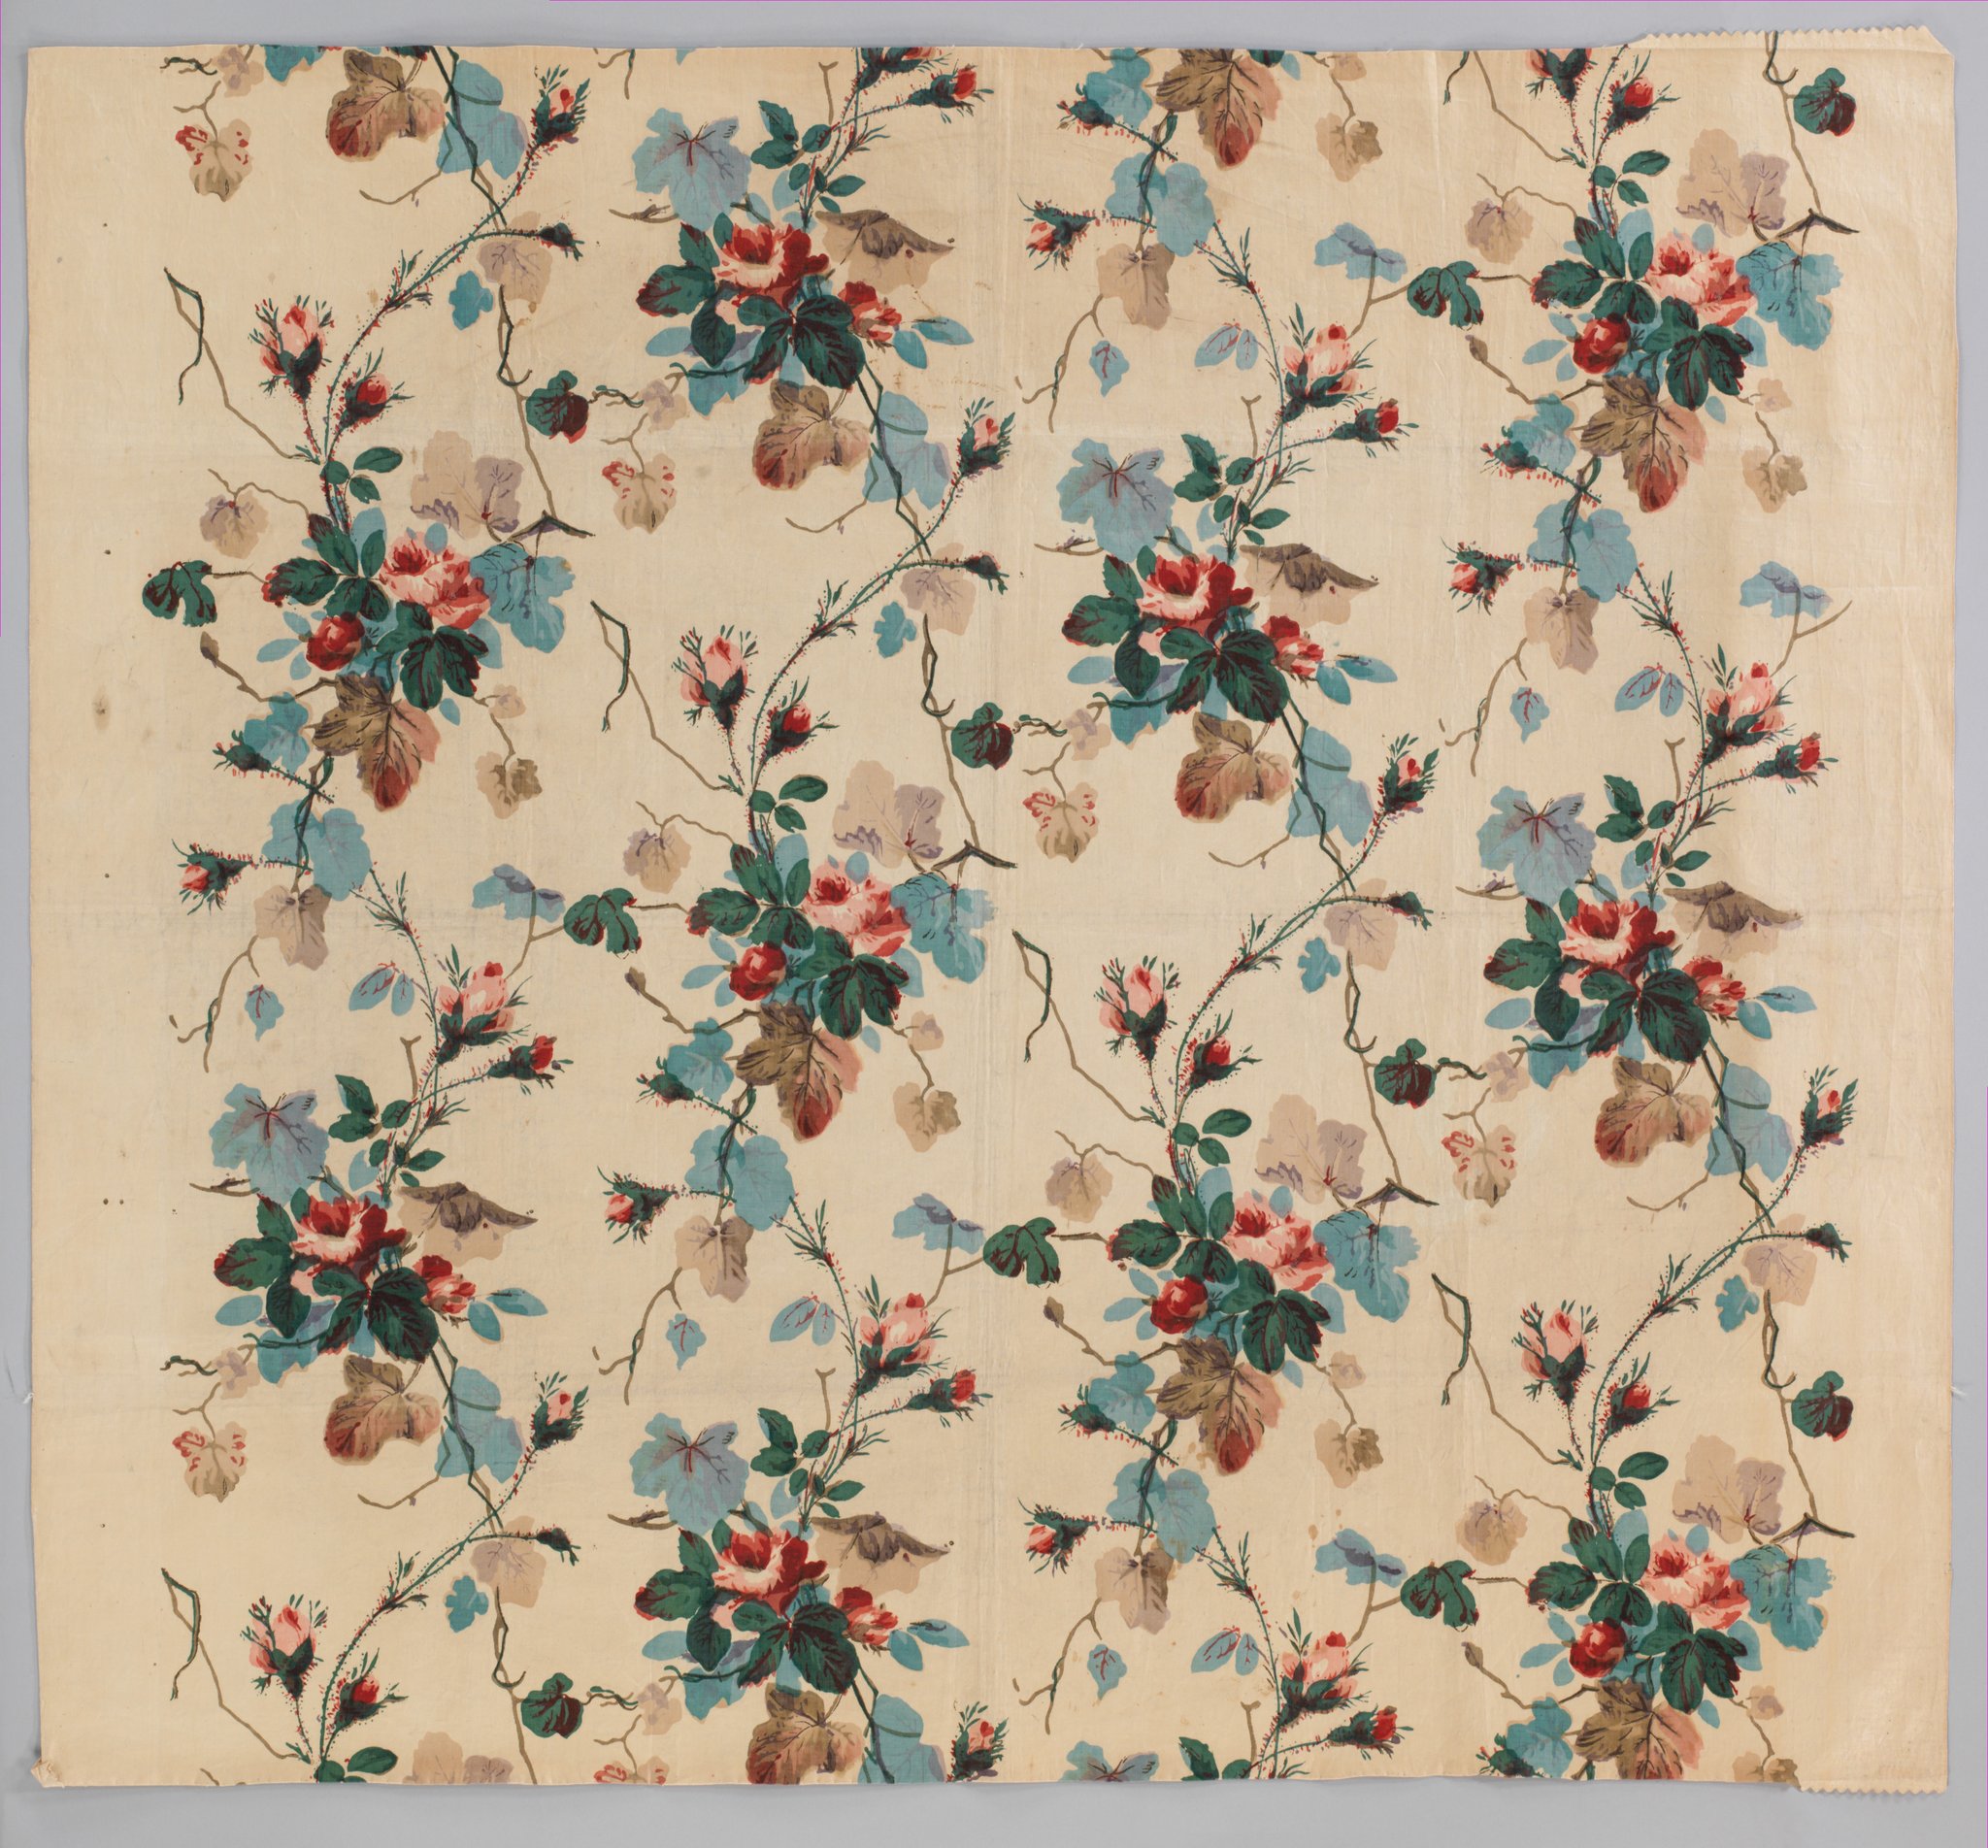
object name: piece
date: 1870-1875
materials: cotton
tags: flowers